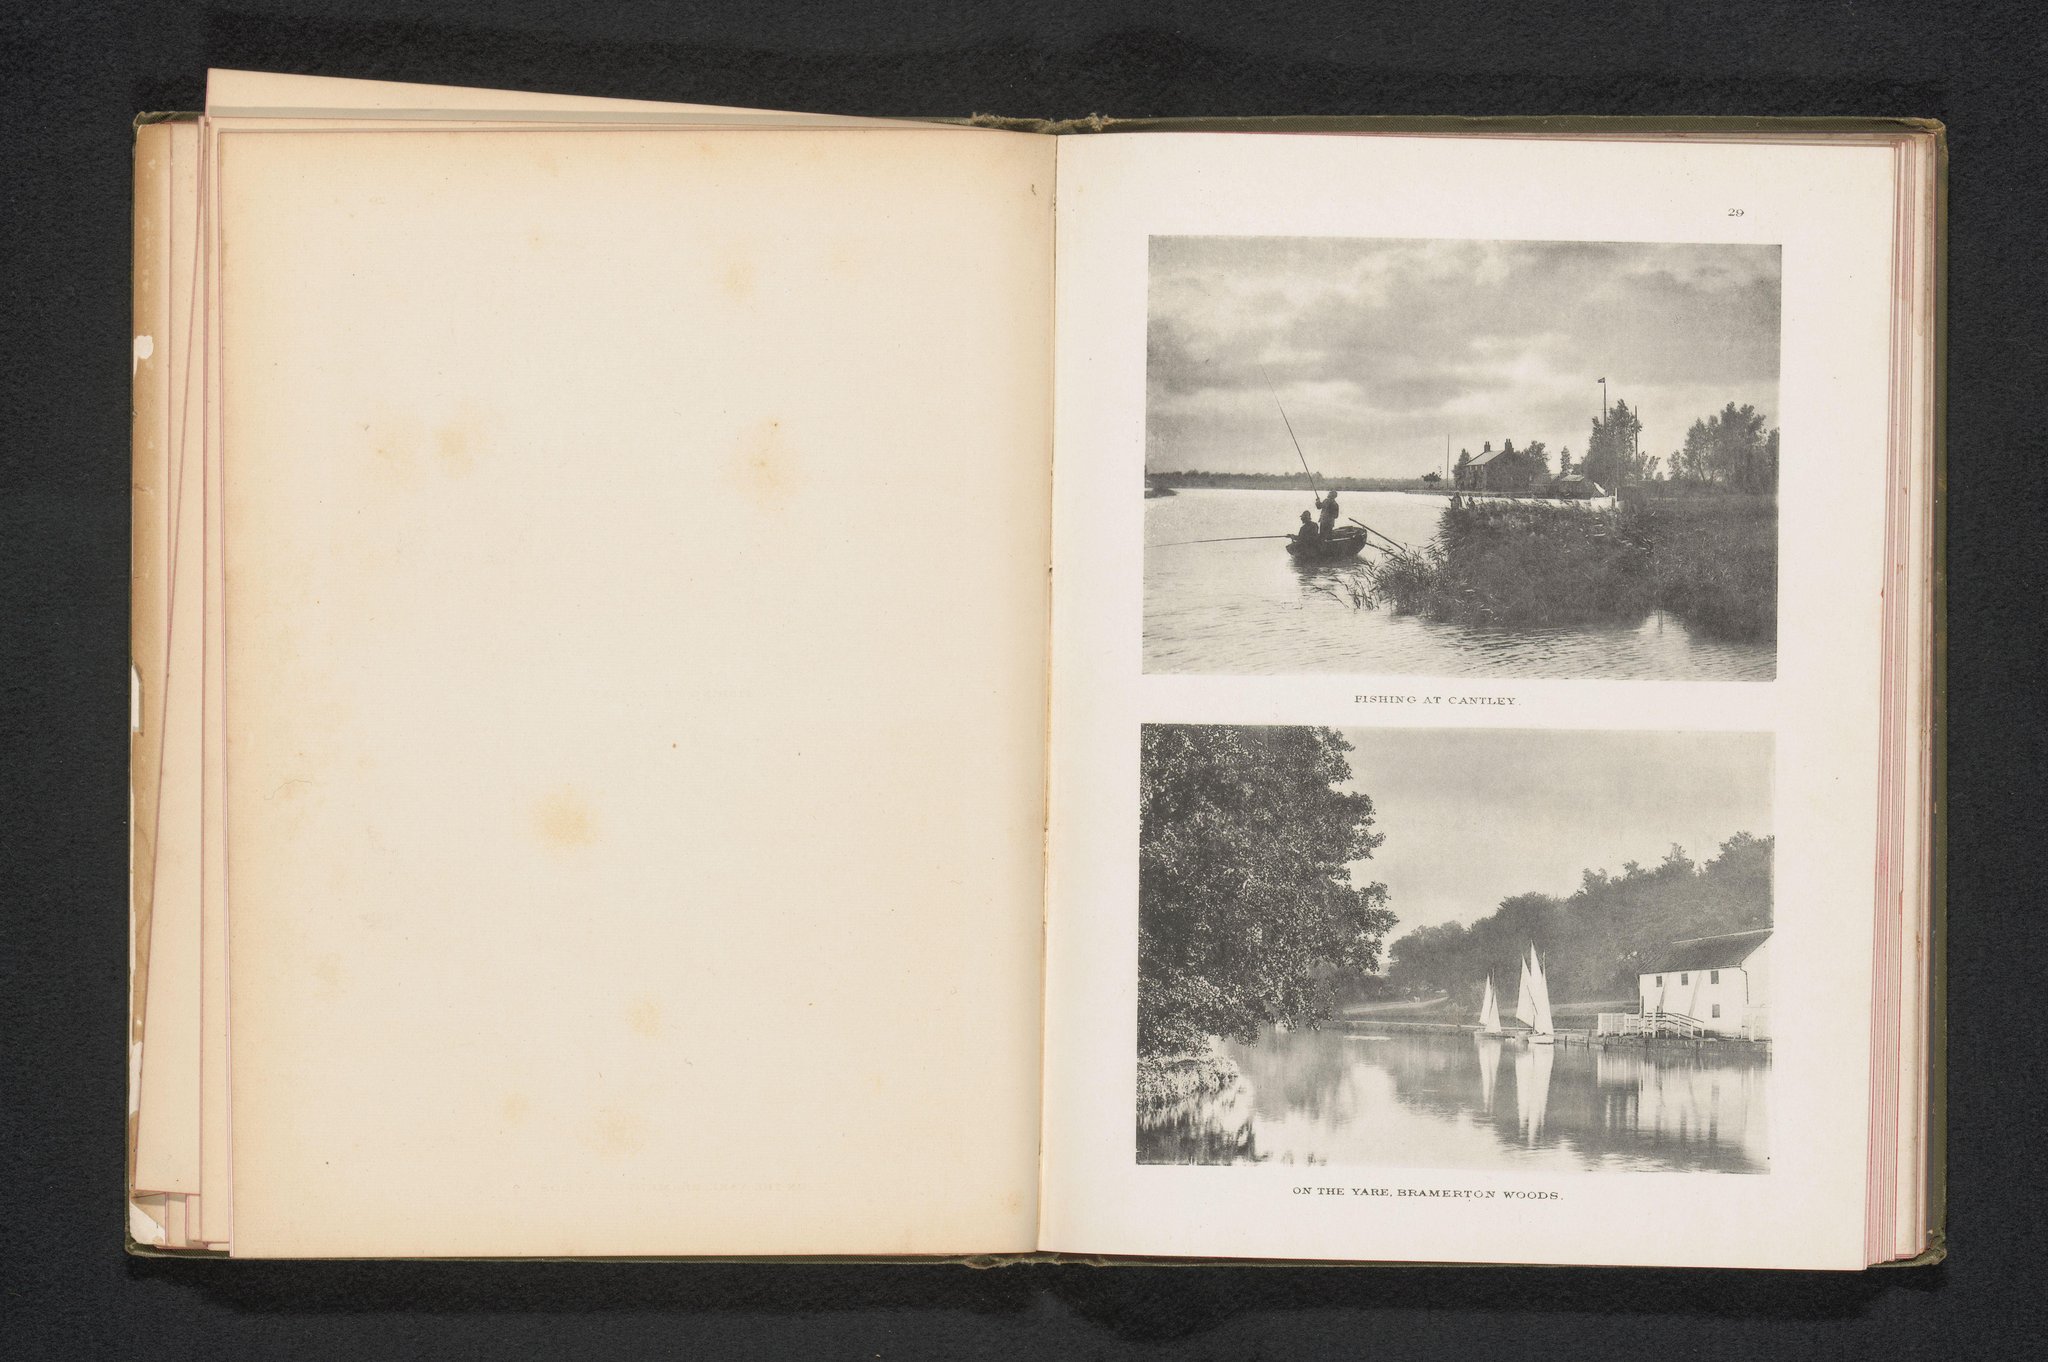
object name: photomechanical print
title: Fishing at Cantley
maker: john payne jennings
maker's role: fotograaf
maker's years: 1843-1926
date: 1886-1891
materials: paper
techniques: photograph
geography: surrey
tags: landscapes with waters, waterscapes, seascapes (in the temperate zone), fishing (sports)